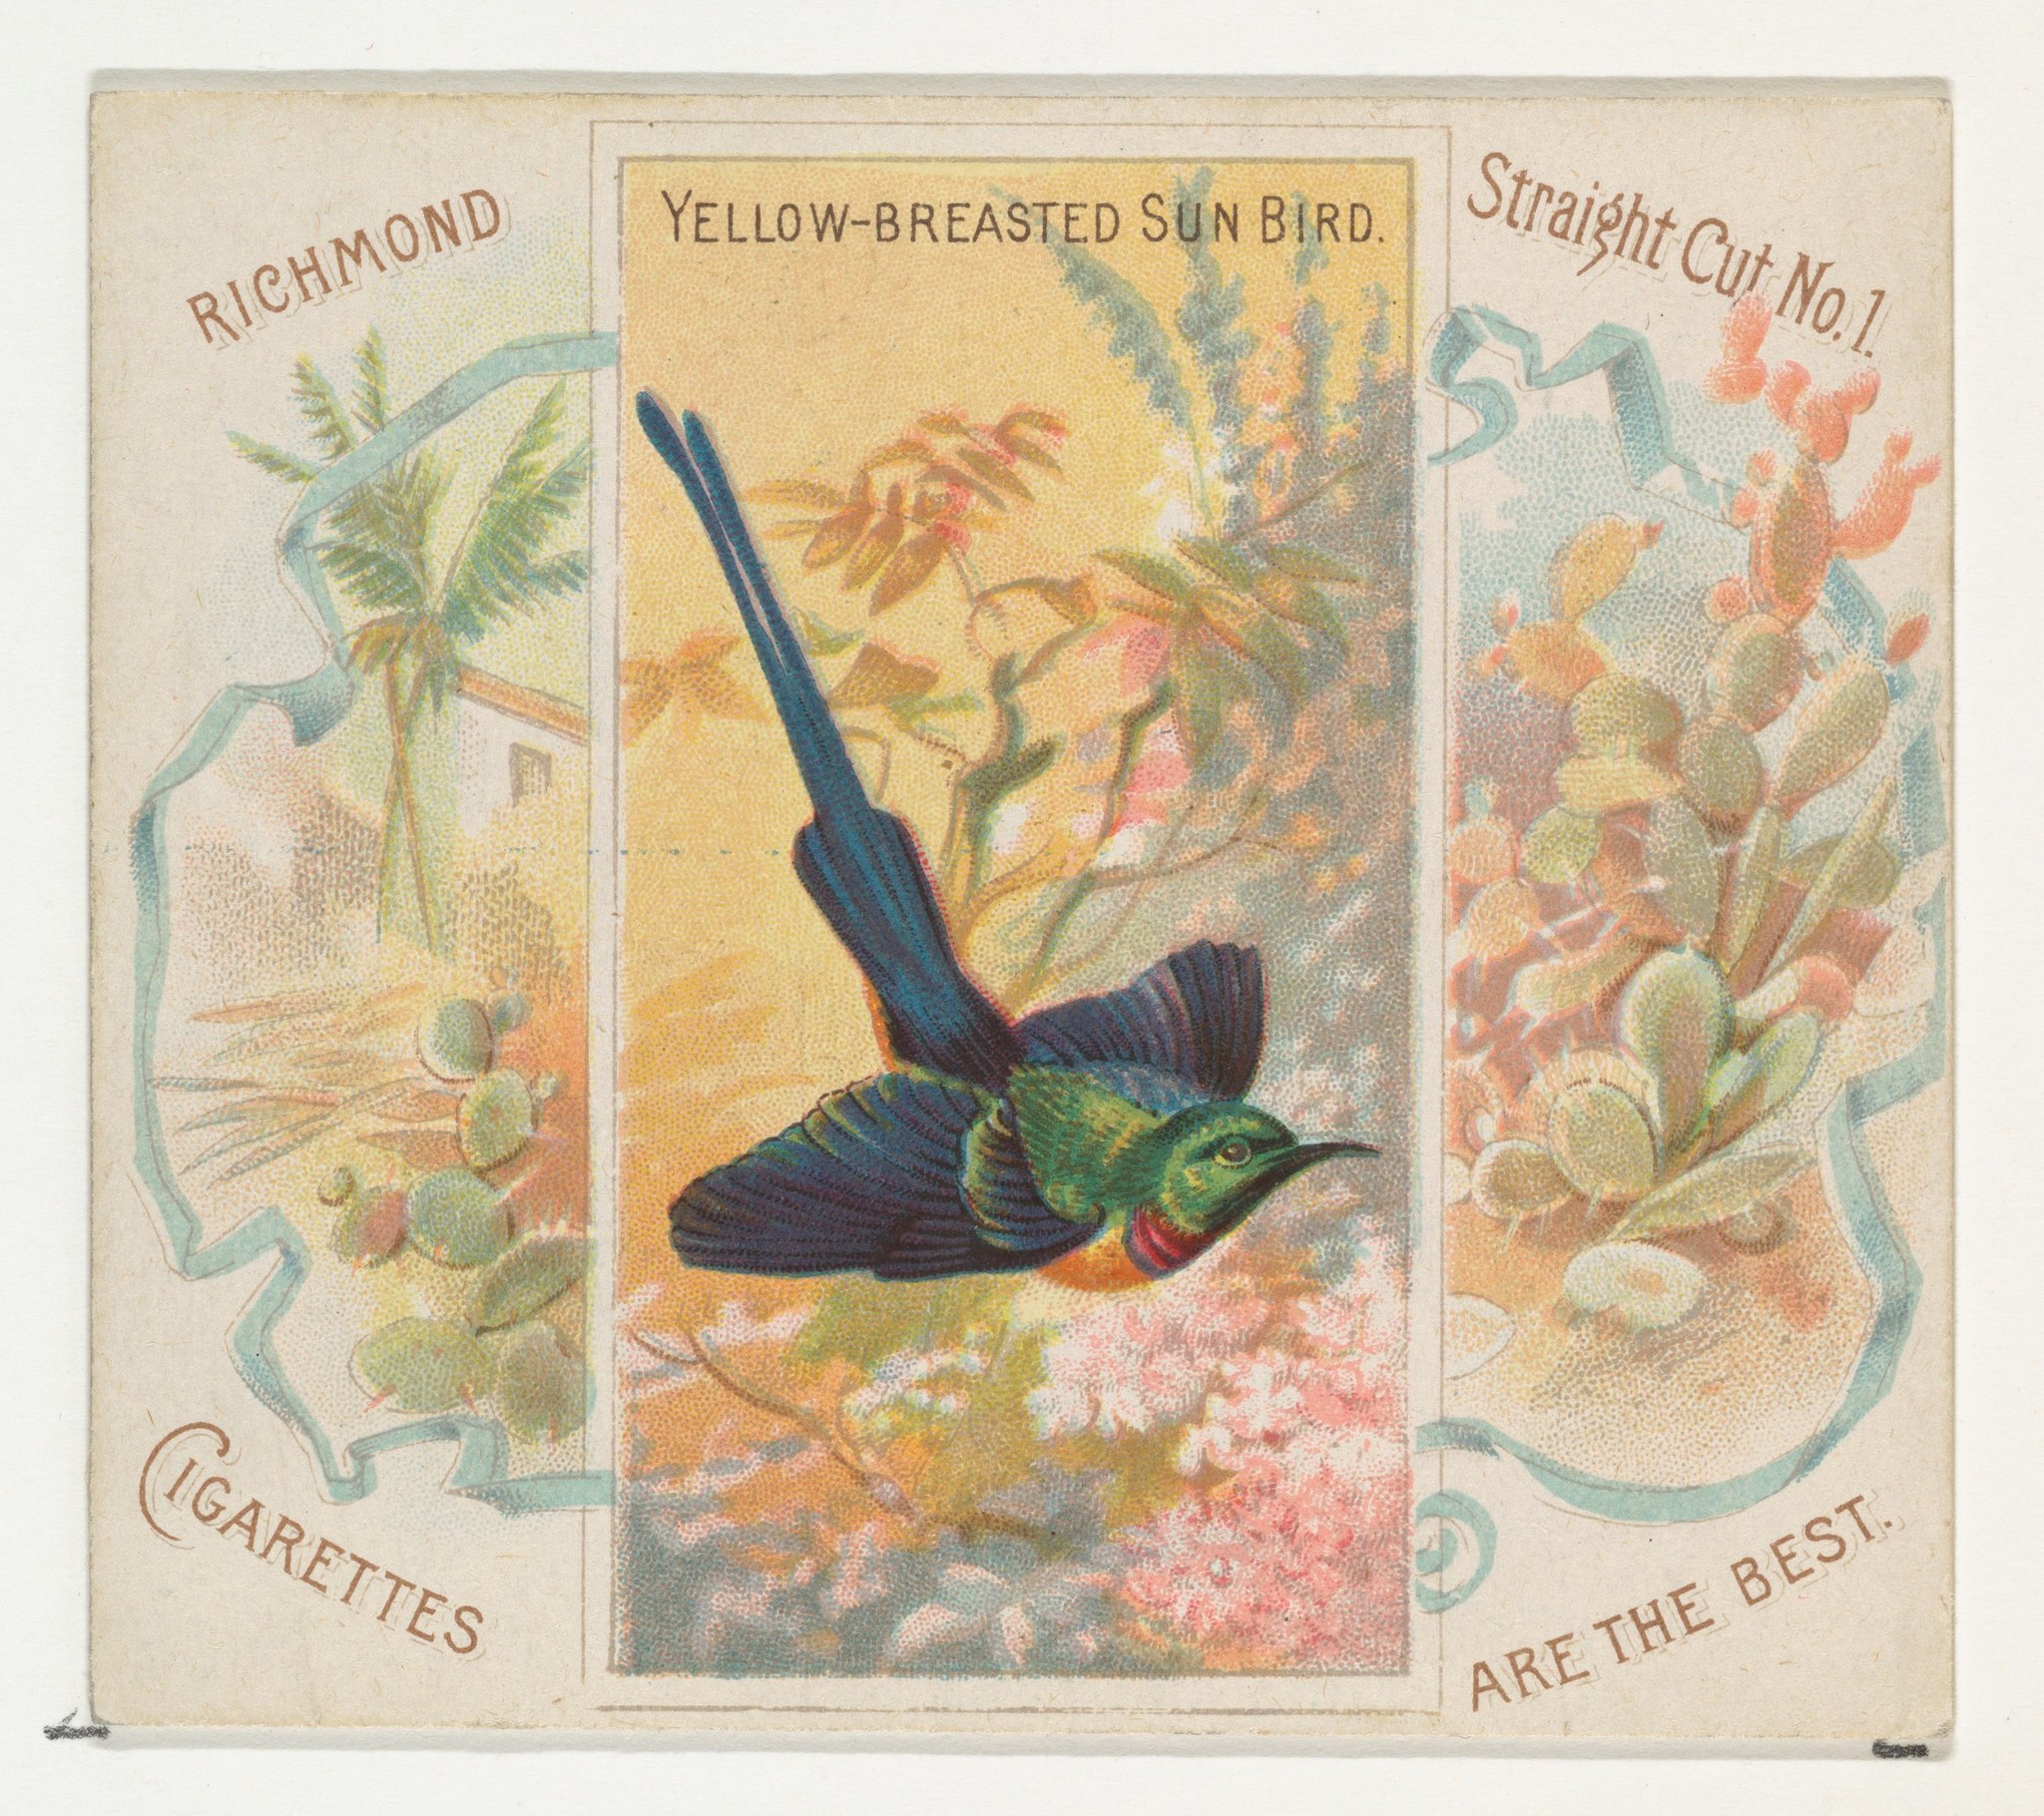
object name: print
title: Yellow-Breasted Sun Bird, from Birds of the Tropics series (N38) for Allen & Ginter Cigarettes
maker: allen & ginter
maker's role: publisher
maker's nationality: american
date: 1889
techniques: color lithograph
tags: birds